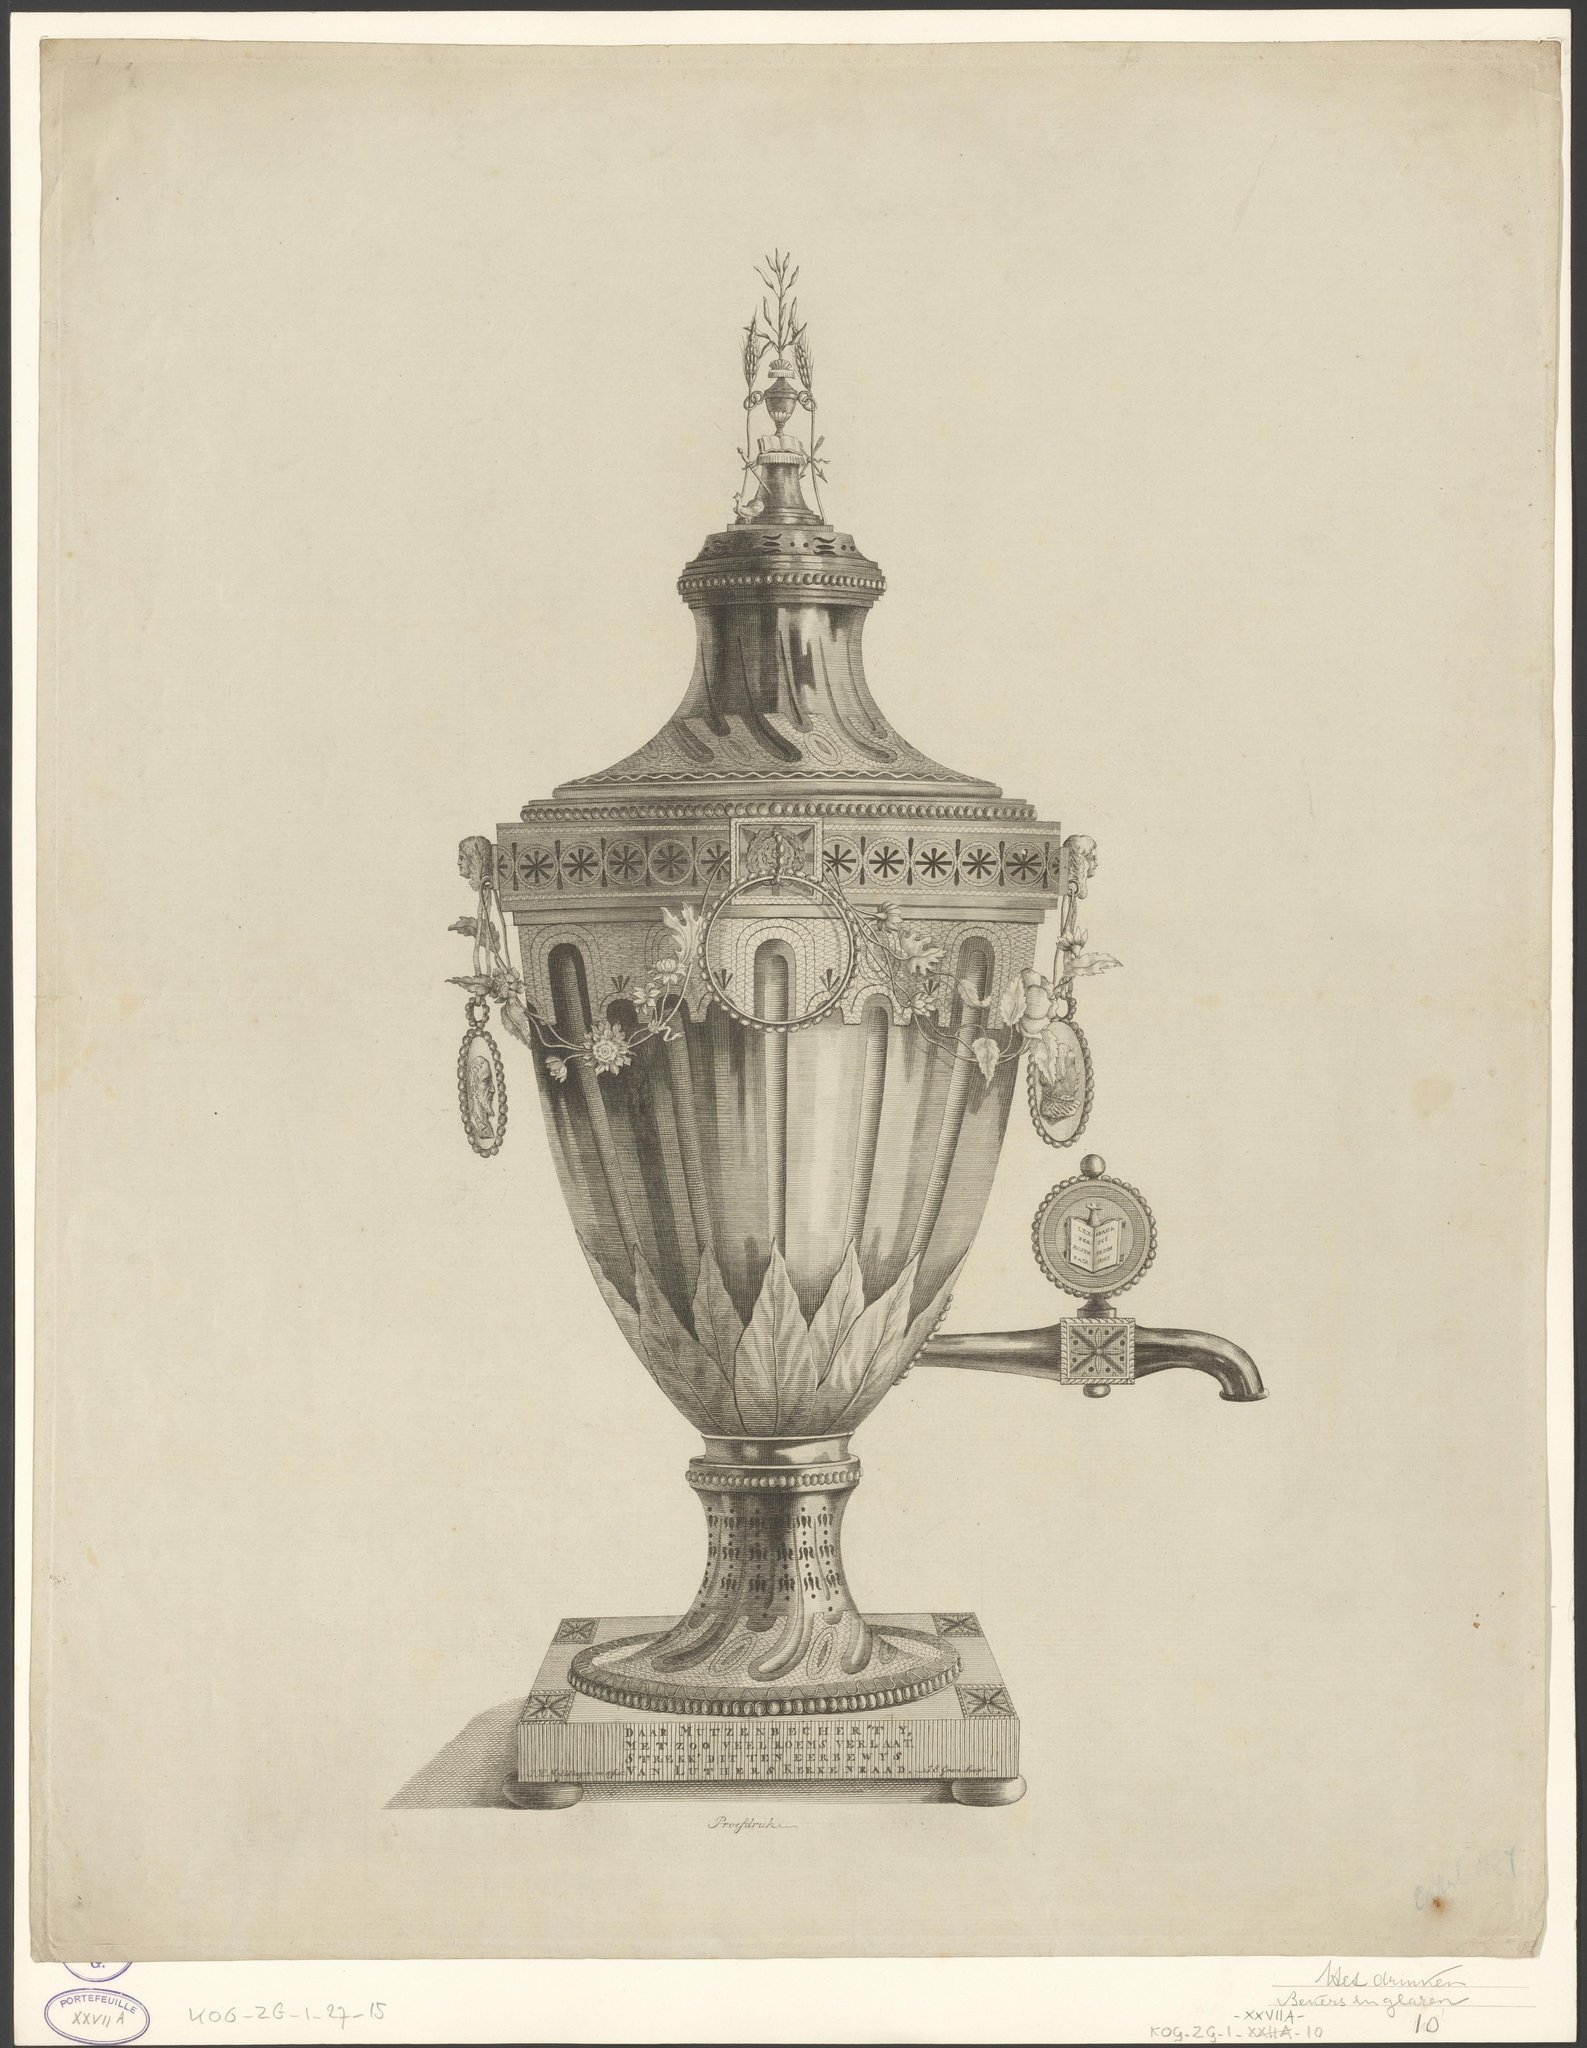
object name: print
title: Ornamentele theepot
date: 1770-1789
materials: paper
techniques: engraving, etching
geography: amsterdam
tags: esdras heinrich mützenbecher, priest, martin luther, alcoholic drinks, tea-pot; samovar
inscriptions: collector's mark, collector's mark: Lugt 1641